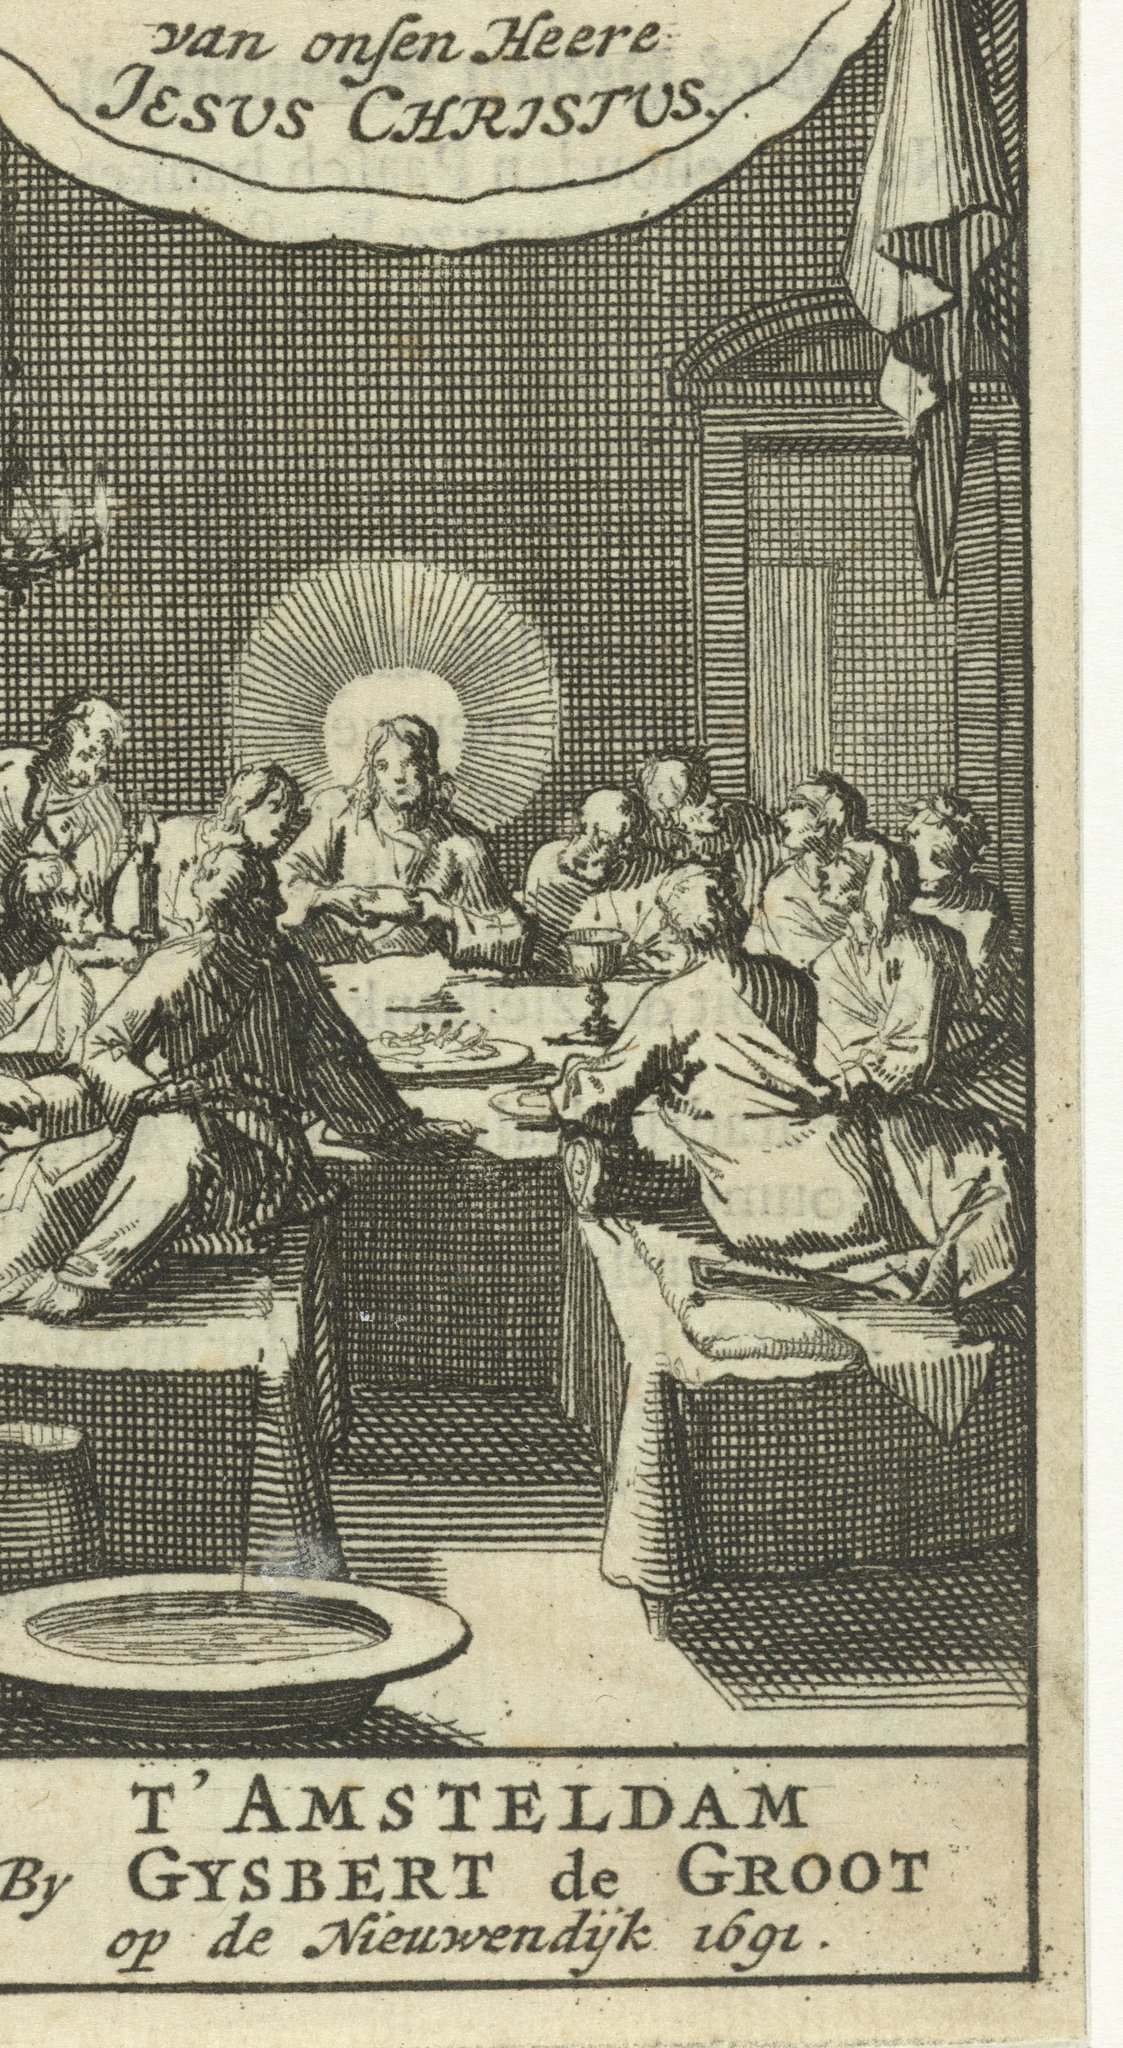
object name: print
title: Christus met zijn discipelen aan het laatste avondmaal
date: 1691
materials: paper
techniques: etching, letterpress printing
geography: amsterdam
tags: last supper (in general) (matthew 26:21-35; mark 14:18-31; luke 22:3, 22:15-23; john 13:21-38)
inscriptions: collector's mark: Lugt 2228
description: Titelpagina voor: Hakvoord, Barend. Het heilige avondmaal, van onzen Heer en Zaligmaker Jesus Christus. Amsterdam: Gijsbert de Groot, 1691.